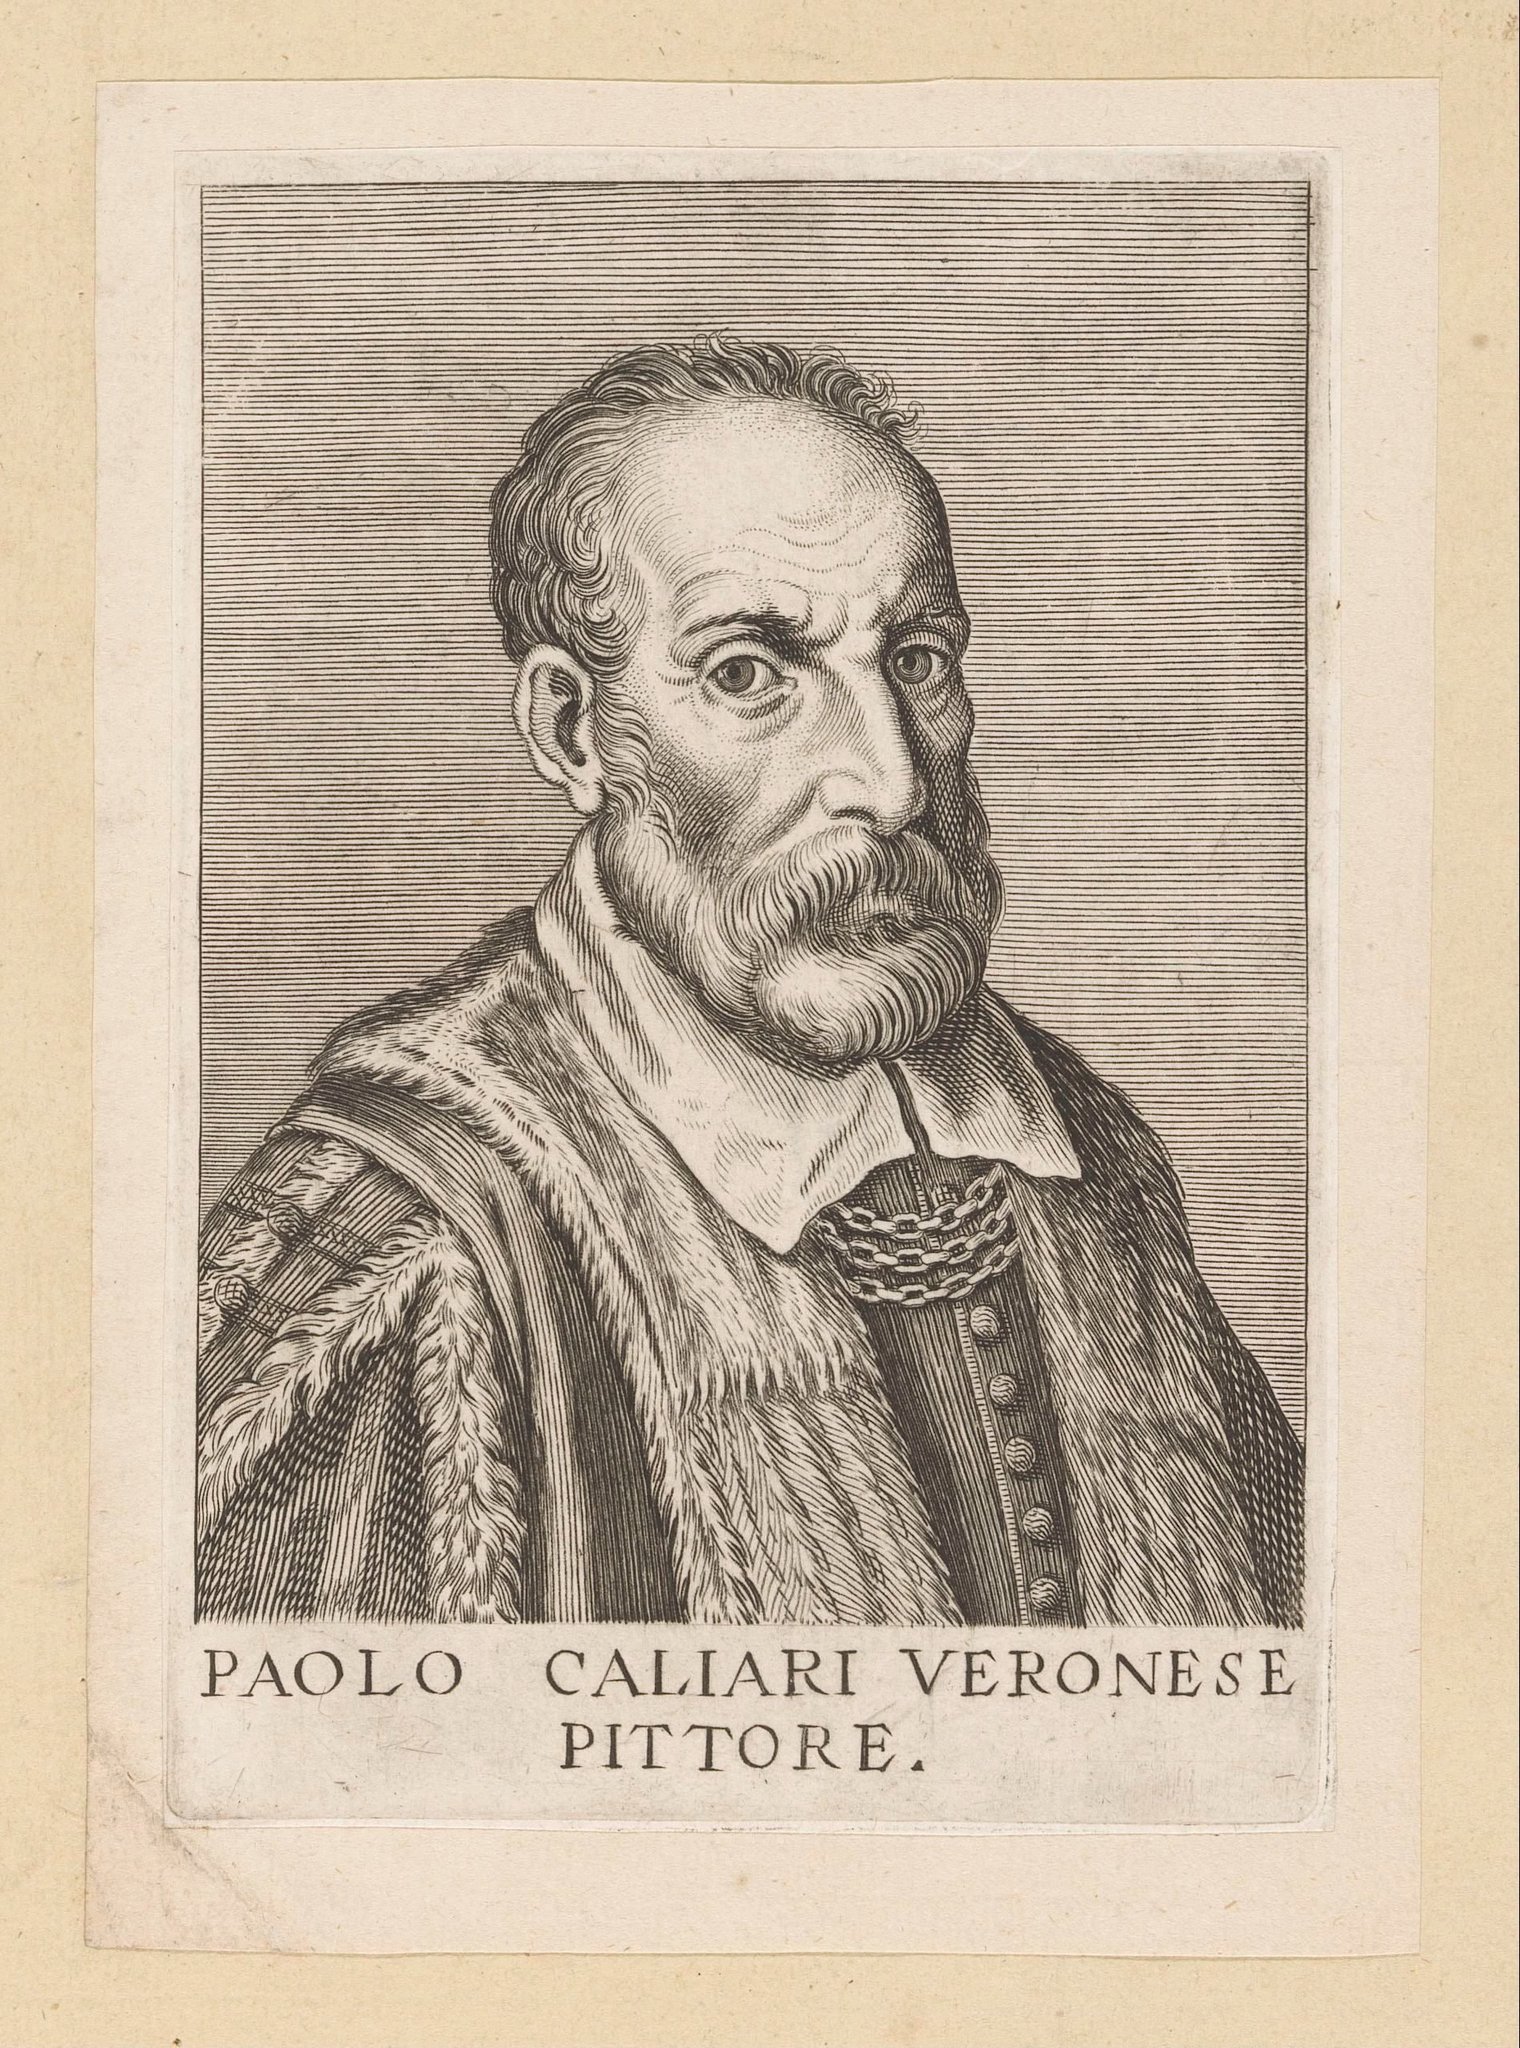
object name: print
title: Portretten van beroemde Italiaanse schilders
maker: monogrammist ip (italië)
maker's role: print maker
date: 1600-1699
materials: paper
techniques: engraving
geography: italy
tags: venice, painter, draughtsman, paolo veronese, historical persons, portrait, self-portrait of artist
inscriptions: collector's mark: Lugt 2228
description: Deze prent maakt deel uit van een reeks van ten minste negen portretten van beroemde Italiaanse schilders.